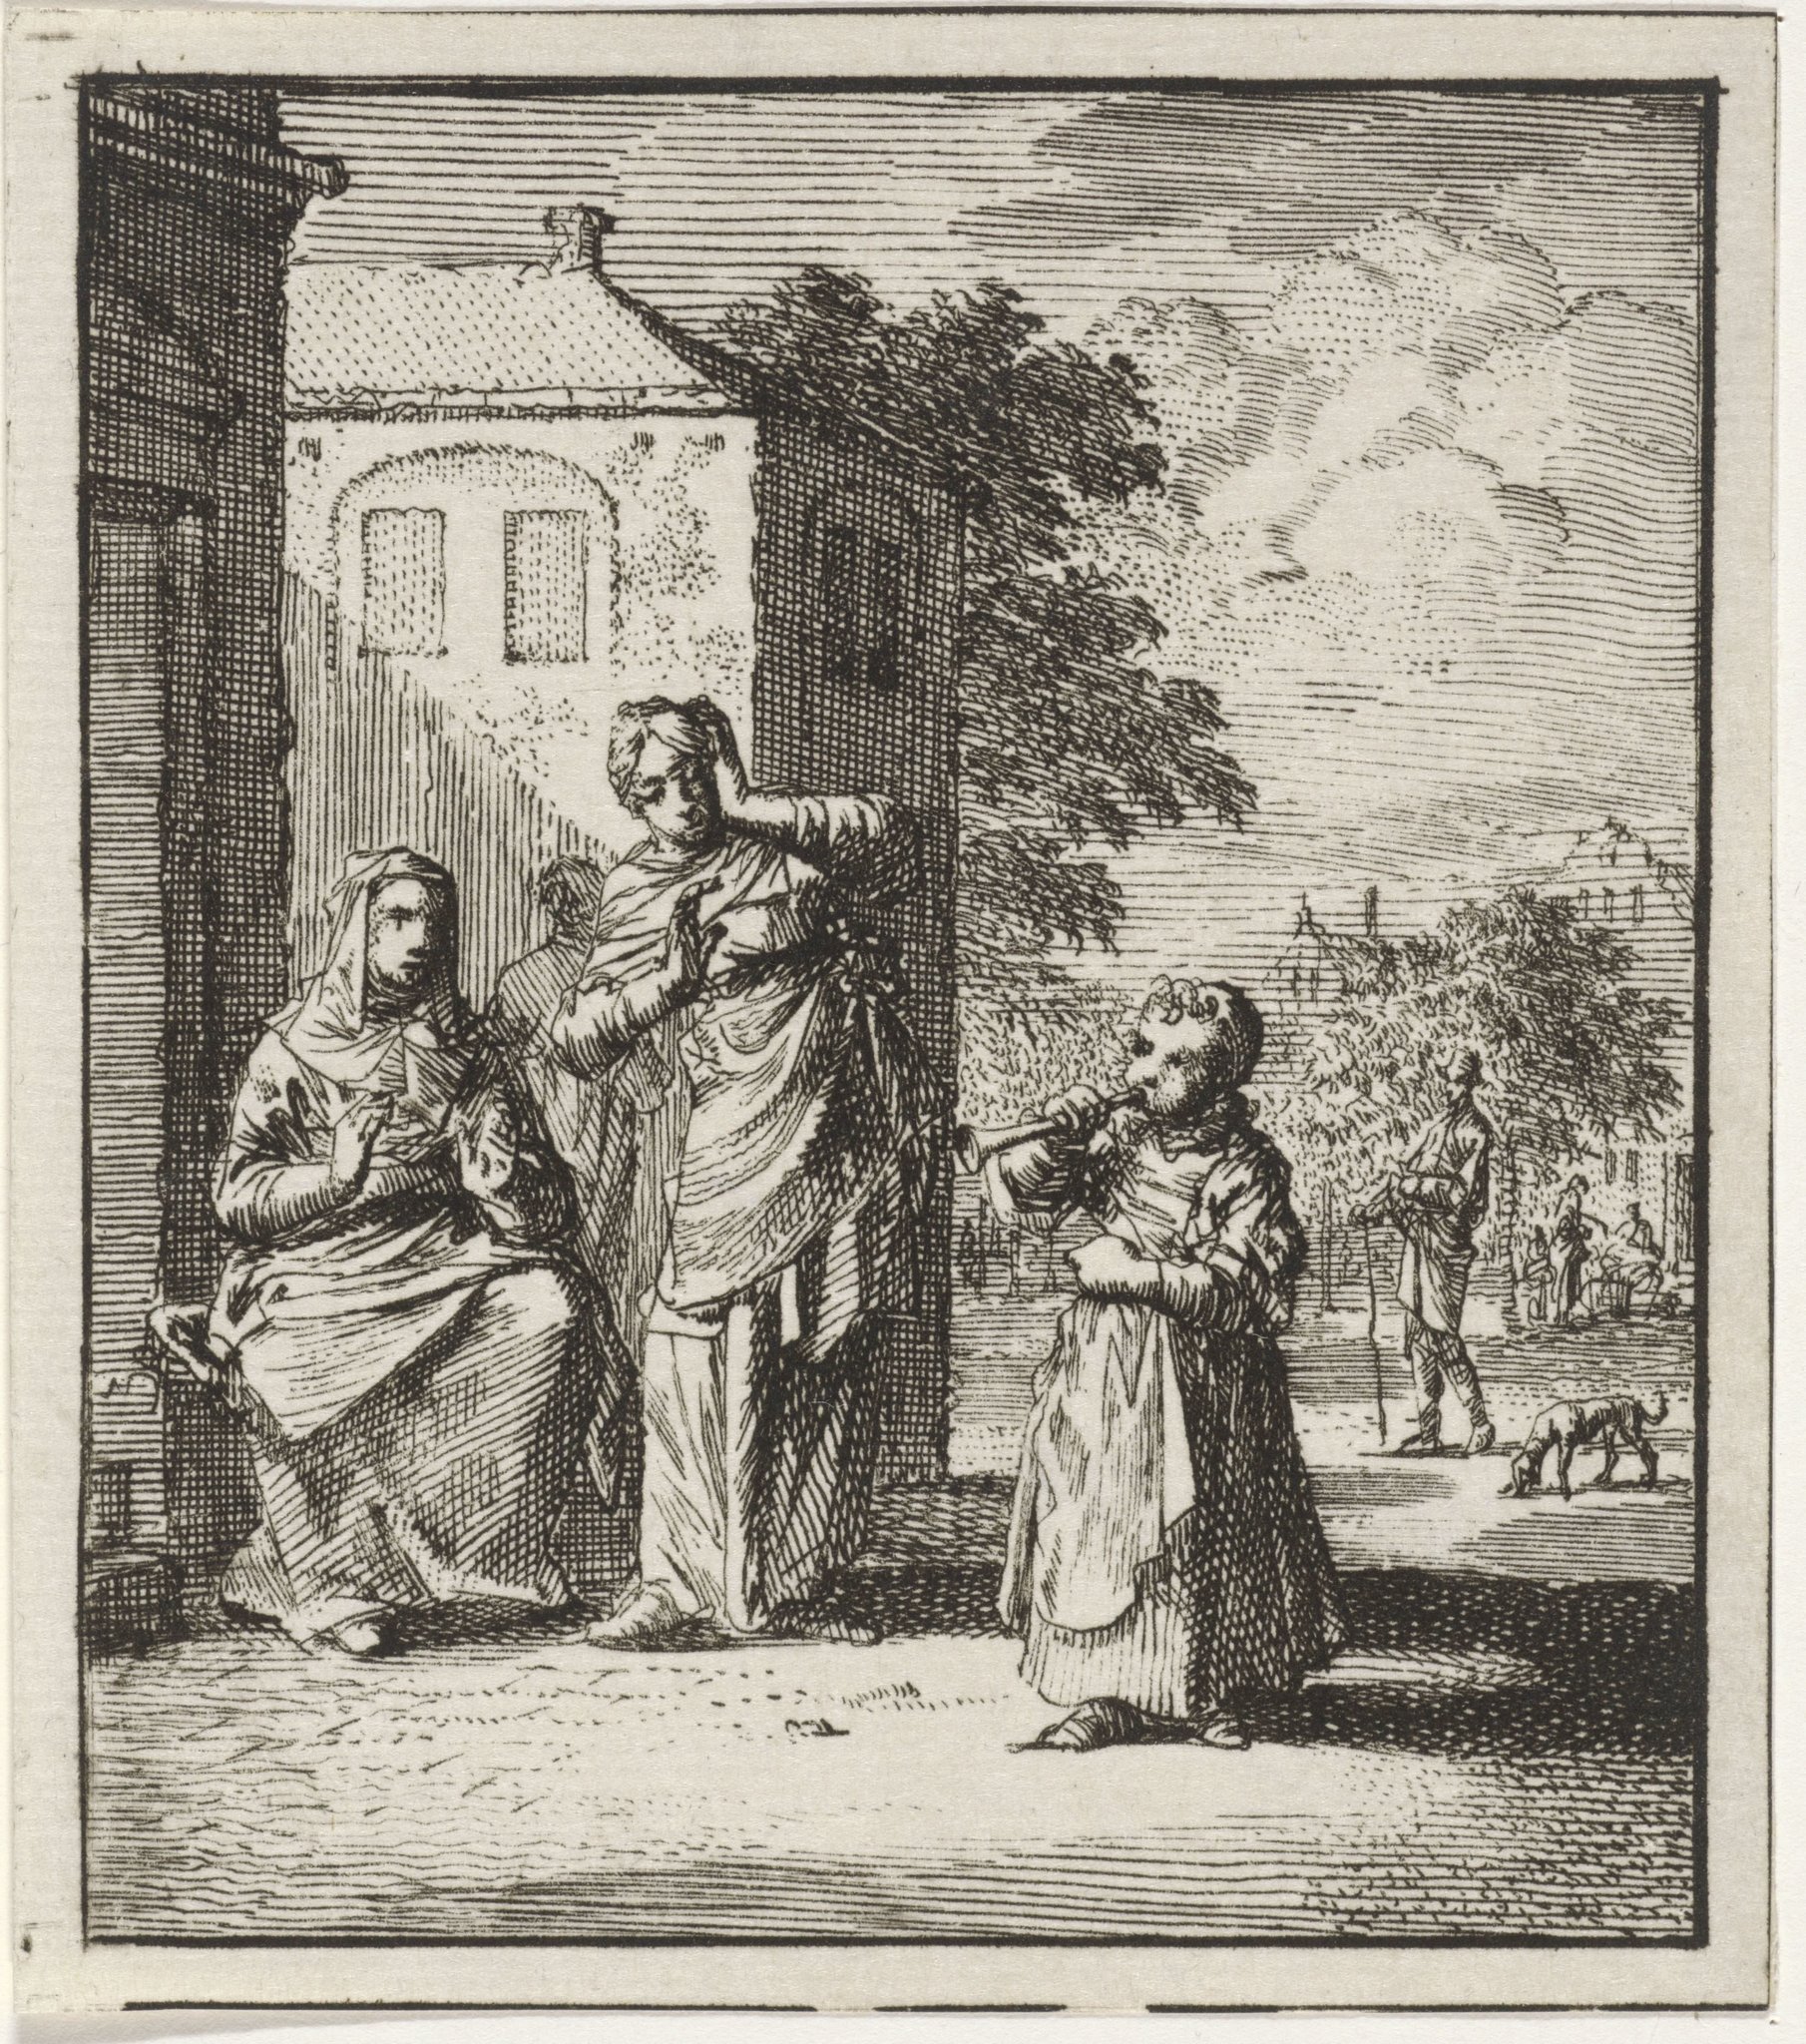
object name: print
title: Kind blazend op een fluit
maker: jan luyken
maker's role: draughtsman, print maker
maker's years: 1649-1712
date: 1712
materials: paper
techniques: etching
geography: amsterdam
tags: 'music' of children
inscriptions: collector's mark: Lugt 2228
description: Proefdruk van illustratie uit: Luyken, Jan. Des menschen begin, midden en einde. Amsterdam: Wed. Pieter Arentsz II en Cornelis van der Sys, 1712, p. 35.